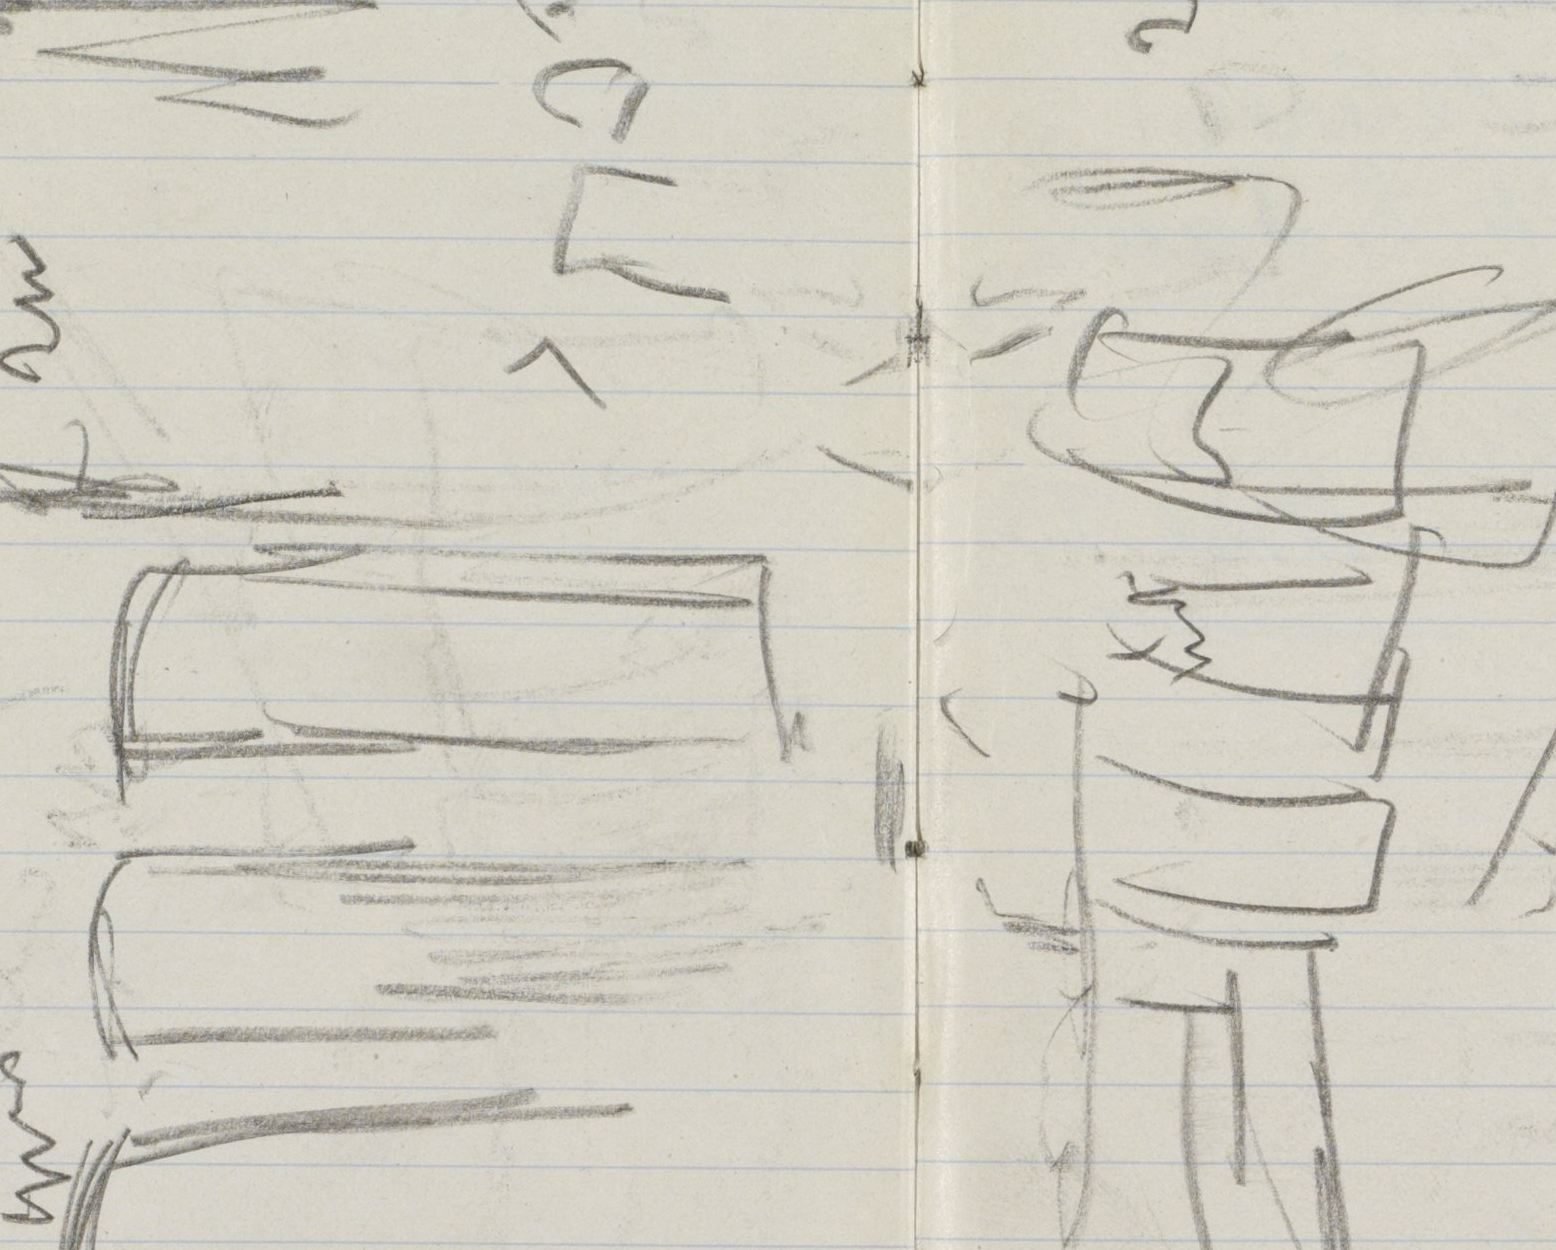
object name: sketchbook leaf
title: Gezicht op de Nieuwendijk te Amsterdam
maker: george hendrik breitner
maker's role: draughtsman, painter, print maker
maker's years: 1857-1923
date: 1892-1900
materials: chalk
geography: amsterdam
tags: civic architecture; edifices; dwellings, street (+ city(-scape) with figures, staffage)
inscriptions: annotation: ‘Nieuwendijk Zondagavond’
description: Pagina 67 en pagina 68 uit een schetsboek met 38 bladen.